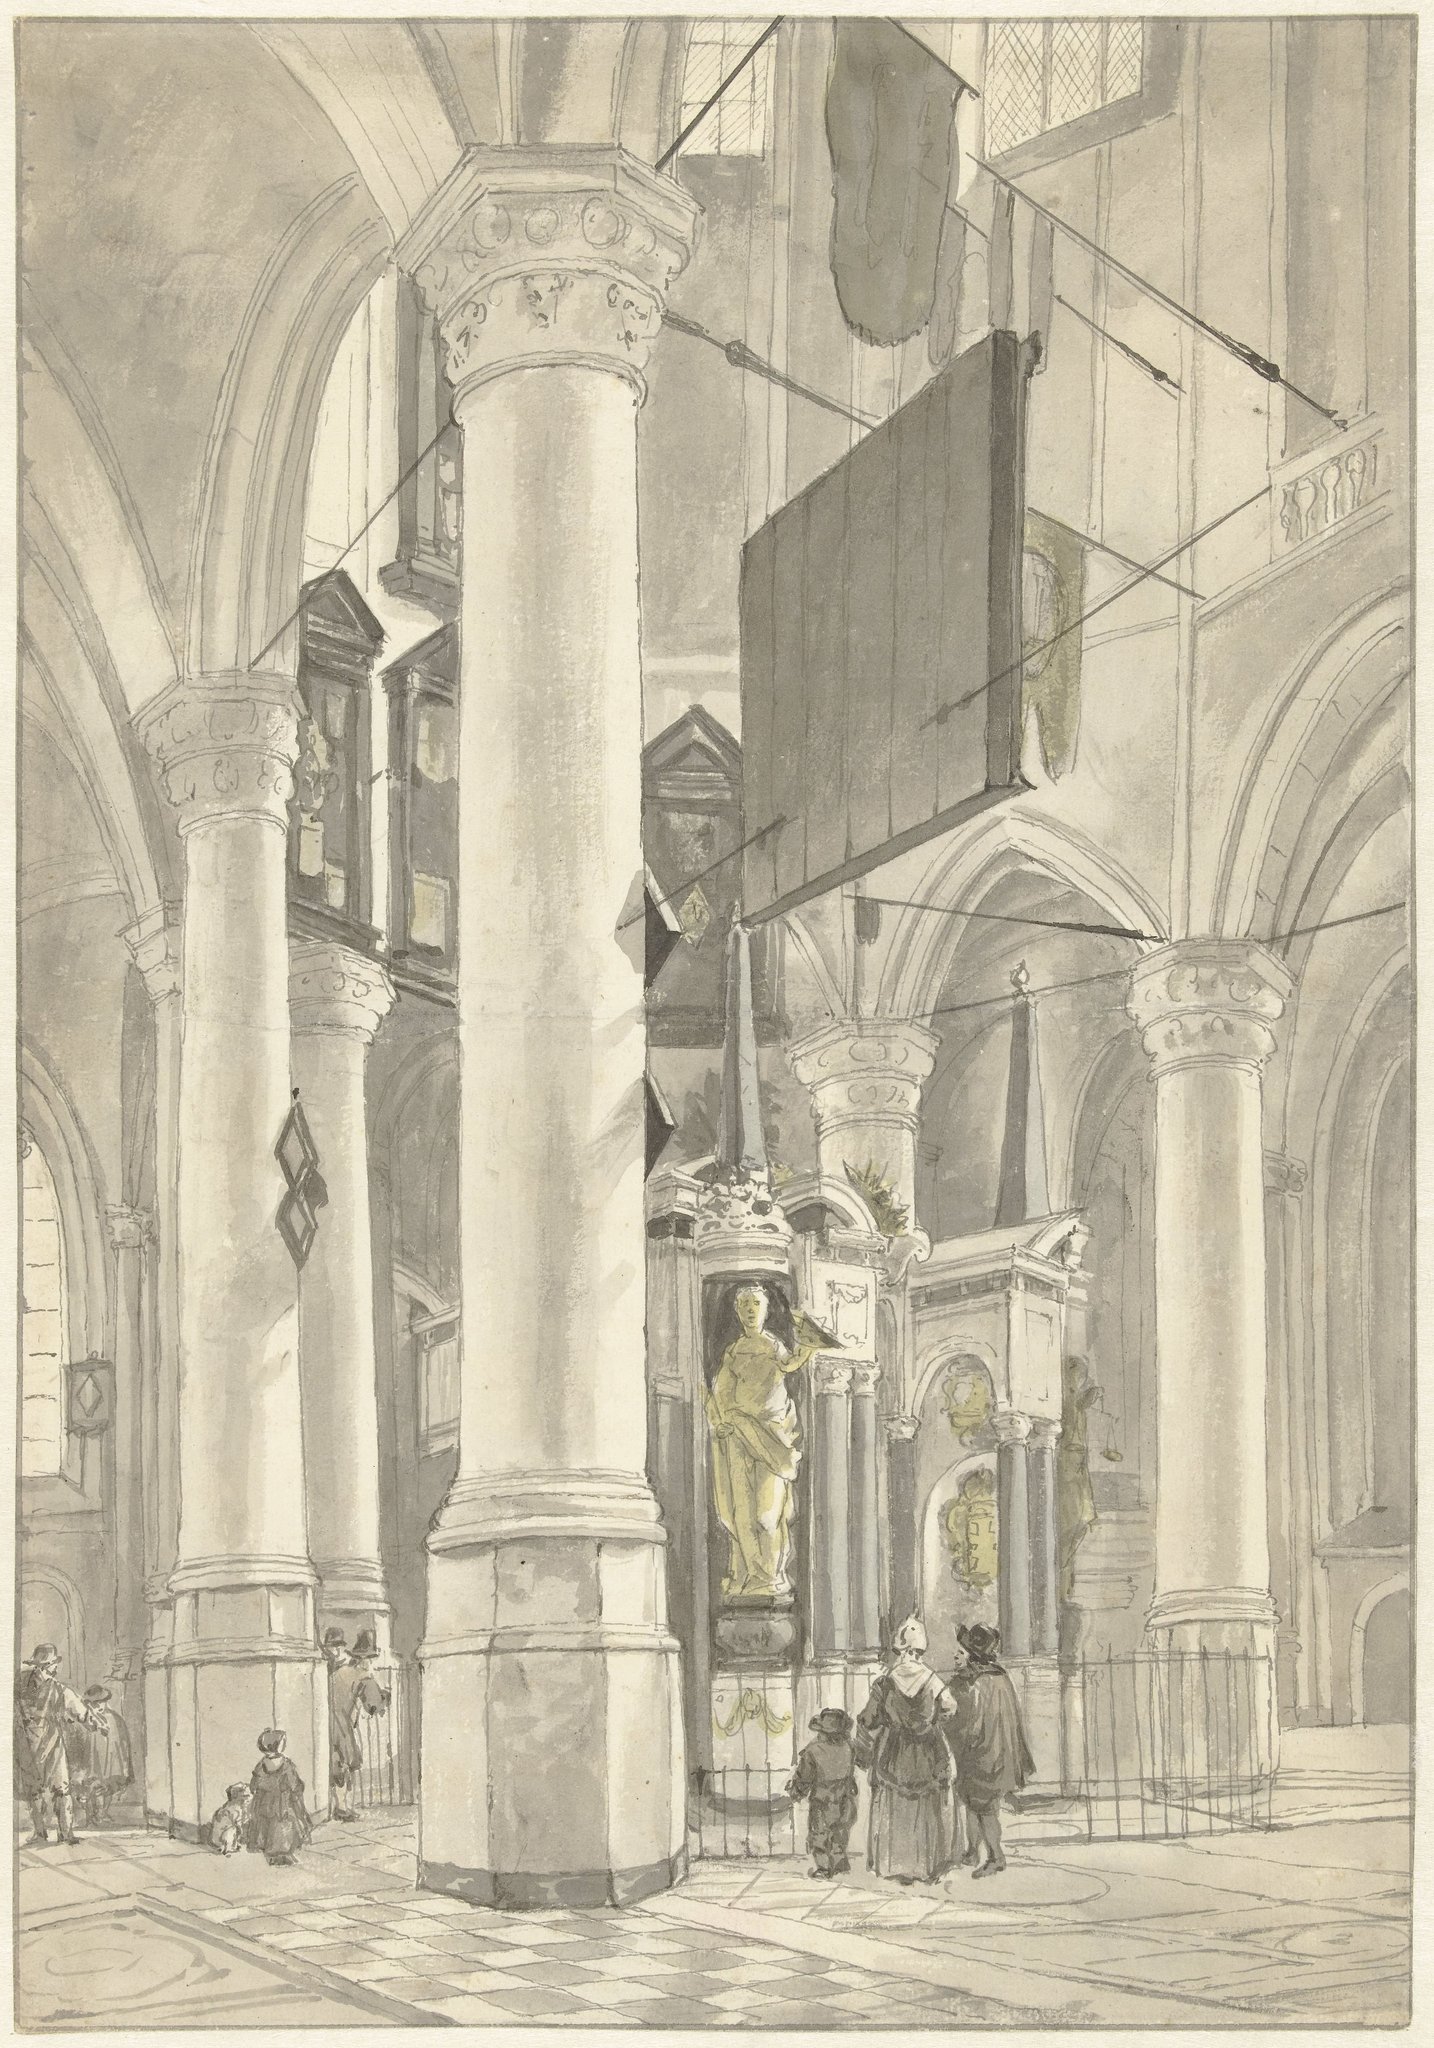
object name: drawing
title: Gezicht in de Nieuwe kerk te Delft, met het grafmonument van Willem van Oranje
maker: wybrand hendriks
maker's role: draughtsman, painter, print maker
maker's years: 1744-1831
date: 1754-1831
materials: ink, paper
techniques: brush, pen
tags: william i (prince of orange), historical persons, interior of church, grave-building, monumental tomb, delft